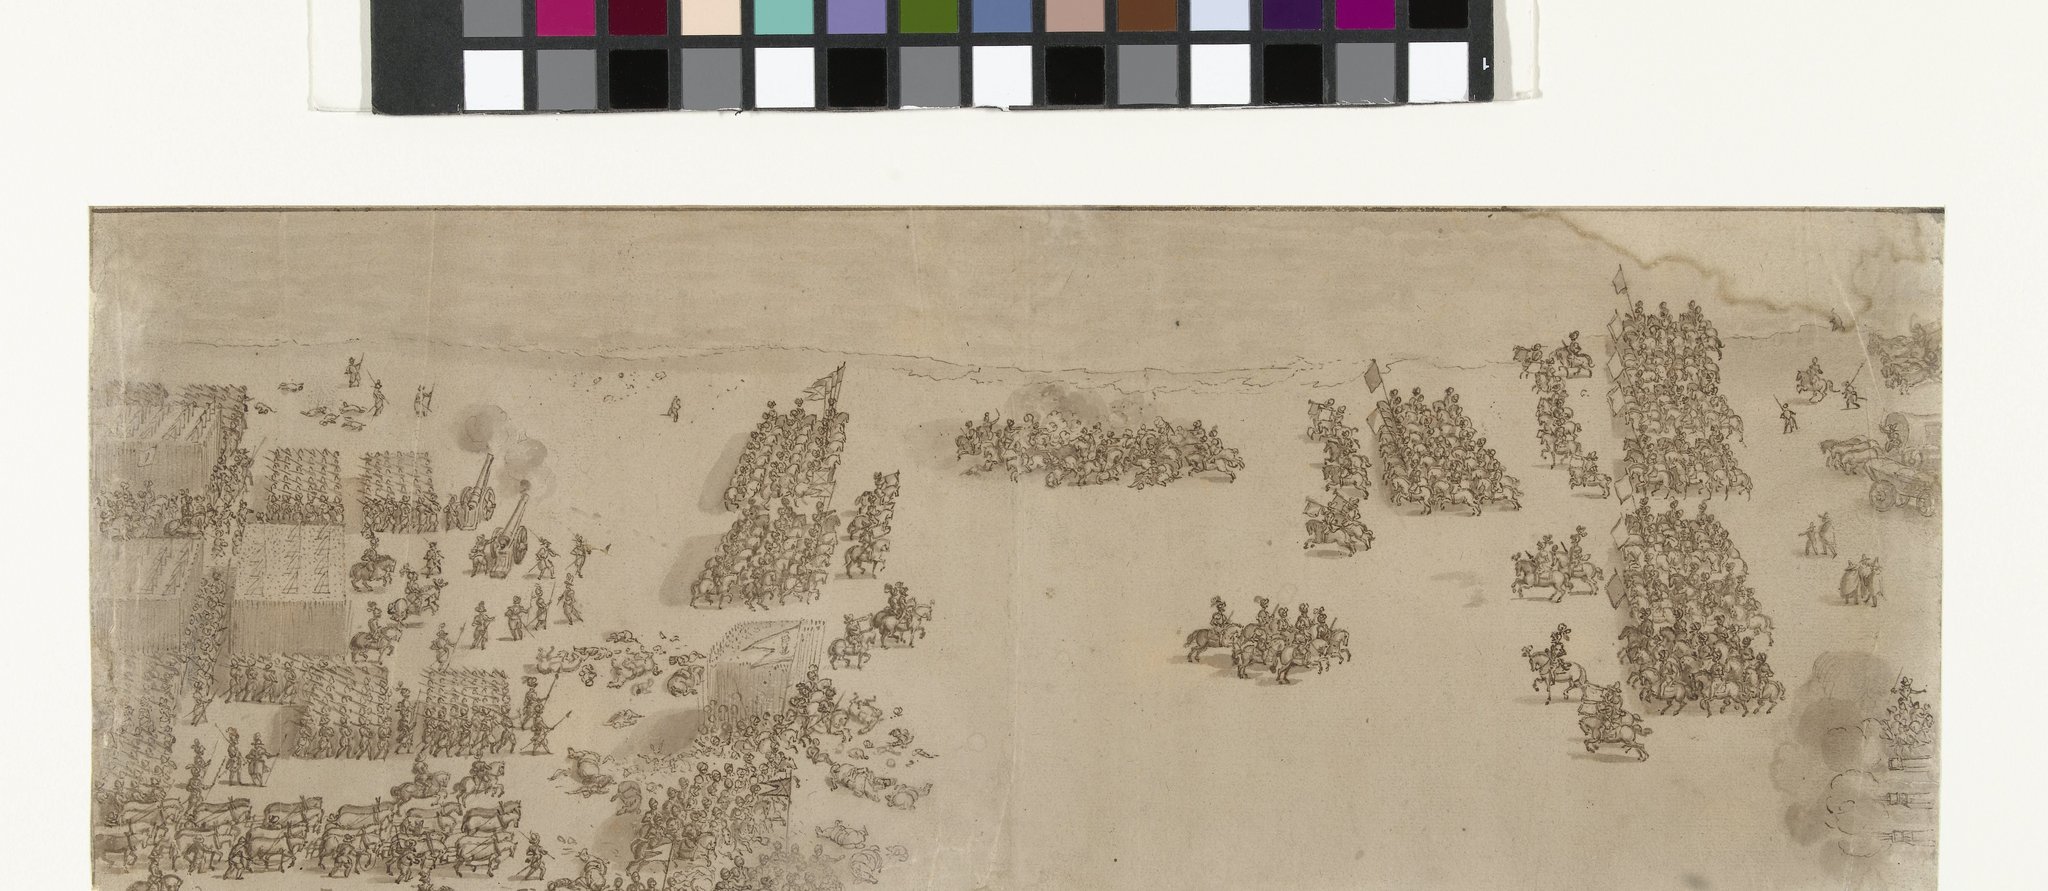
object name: drawing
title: De eerste schermutselingen tussen Staatse en Spaanse soldaten op het strand bij Nieuwpoort, 1600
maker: floris balthasarsz. van berckenrode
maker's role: print maker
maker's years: 1562-1616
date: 1600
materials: paper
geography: northern netherlands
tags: battle (+ land forces), battle of nieuwpoort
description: De eerste schermutselingen tussen Staatse en Spaanse soldaten op het strand bij Nieuwpoort, 2 juli 1600. Links de Spaanse troepen van Albrecht, rechts Staatse cavalerie. Ontwerptekening voor de rechterhelft van de grote prent van Floris Balthasarsz. van Berckenrode. Ontwerp voor een prent.